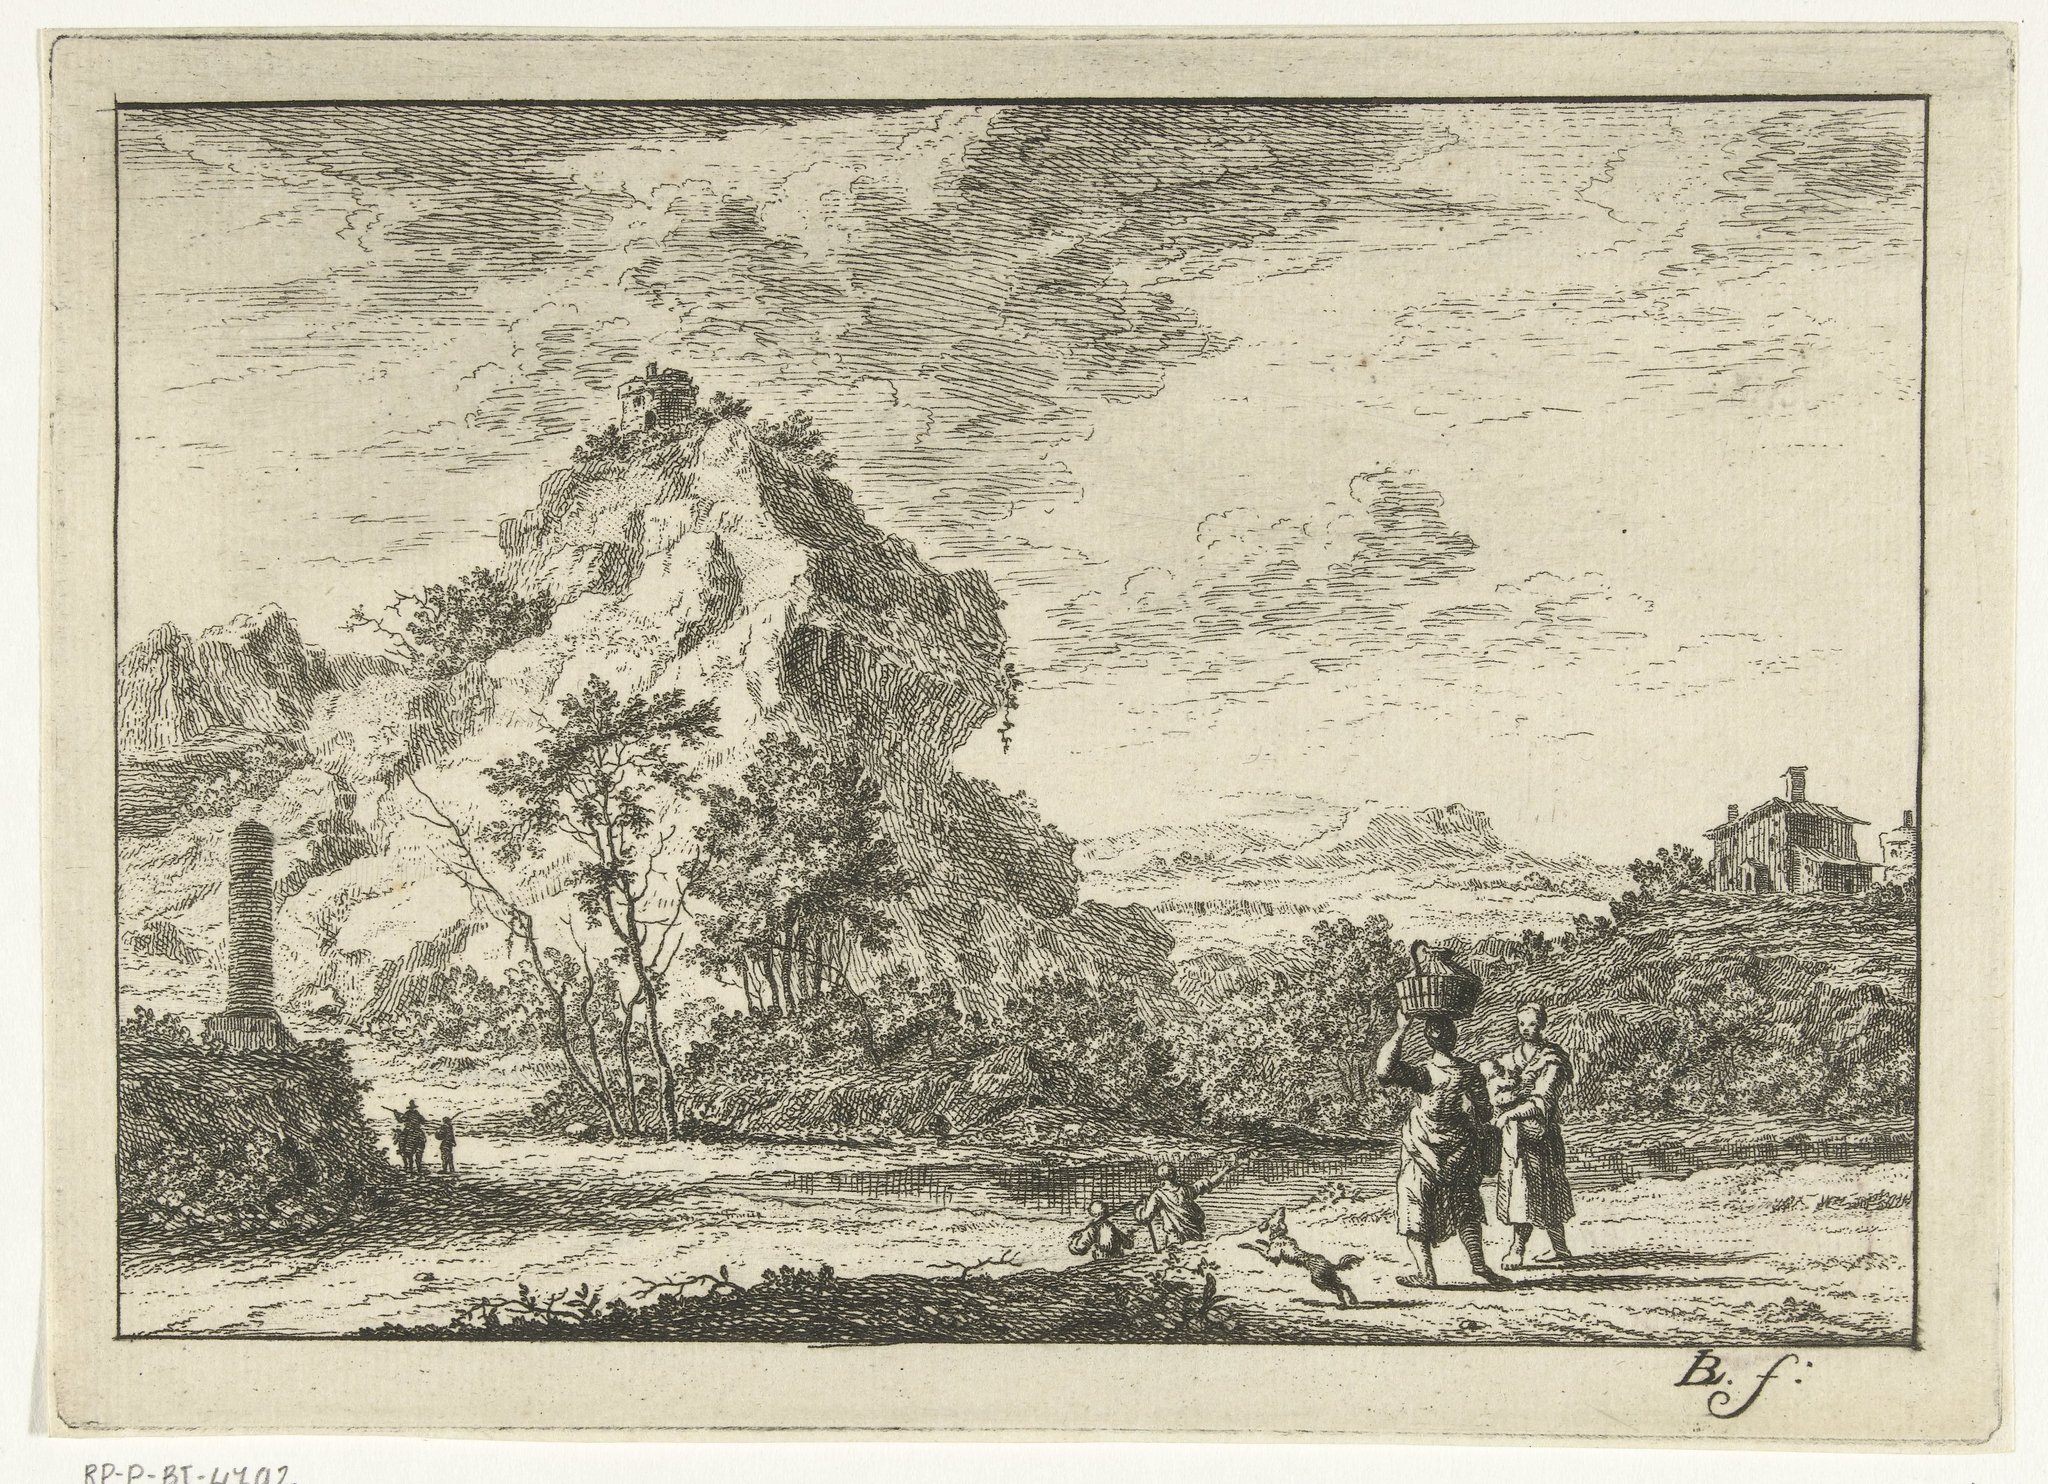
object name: print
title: Heuvelachtig landschap met figuren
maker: leendert brasser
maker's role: draughtsman, print maker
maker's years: 1727-1793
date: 1727-1793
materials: paper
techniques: etching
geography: netherlands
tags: (high) hill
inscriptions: collector's mark: Lugt 240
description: Bij Hollstein en Bartsch ook op naam van Ludolf Backhuizen.